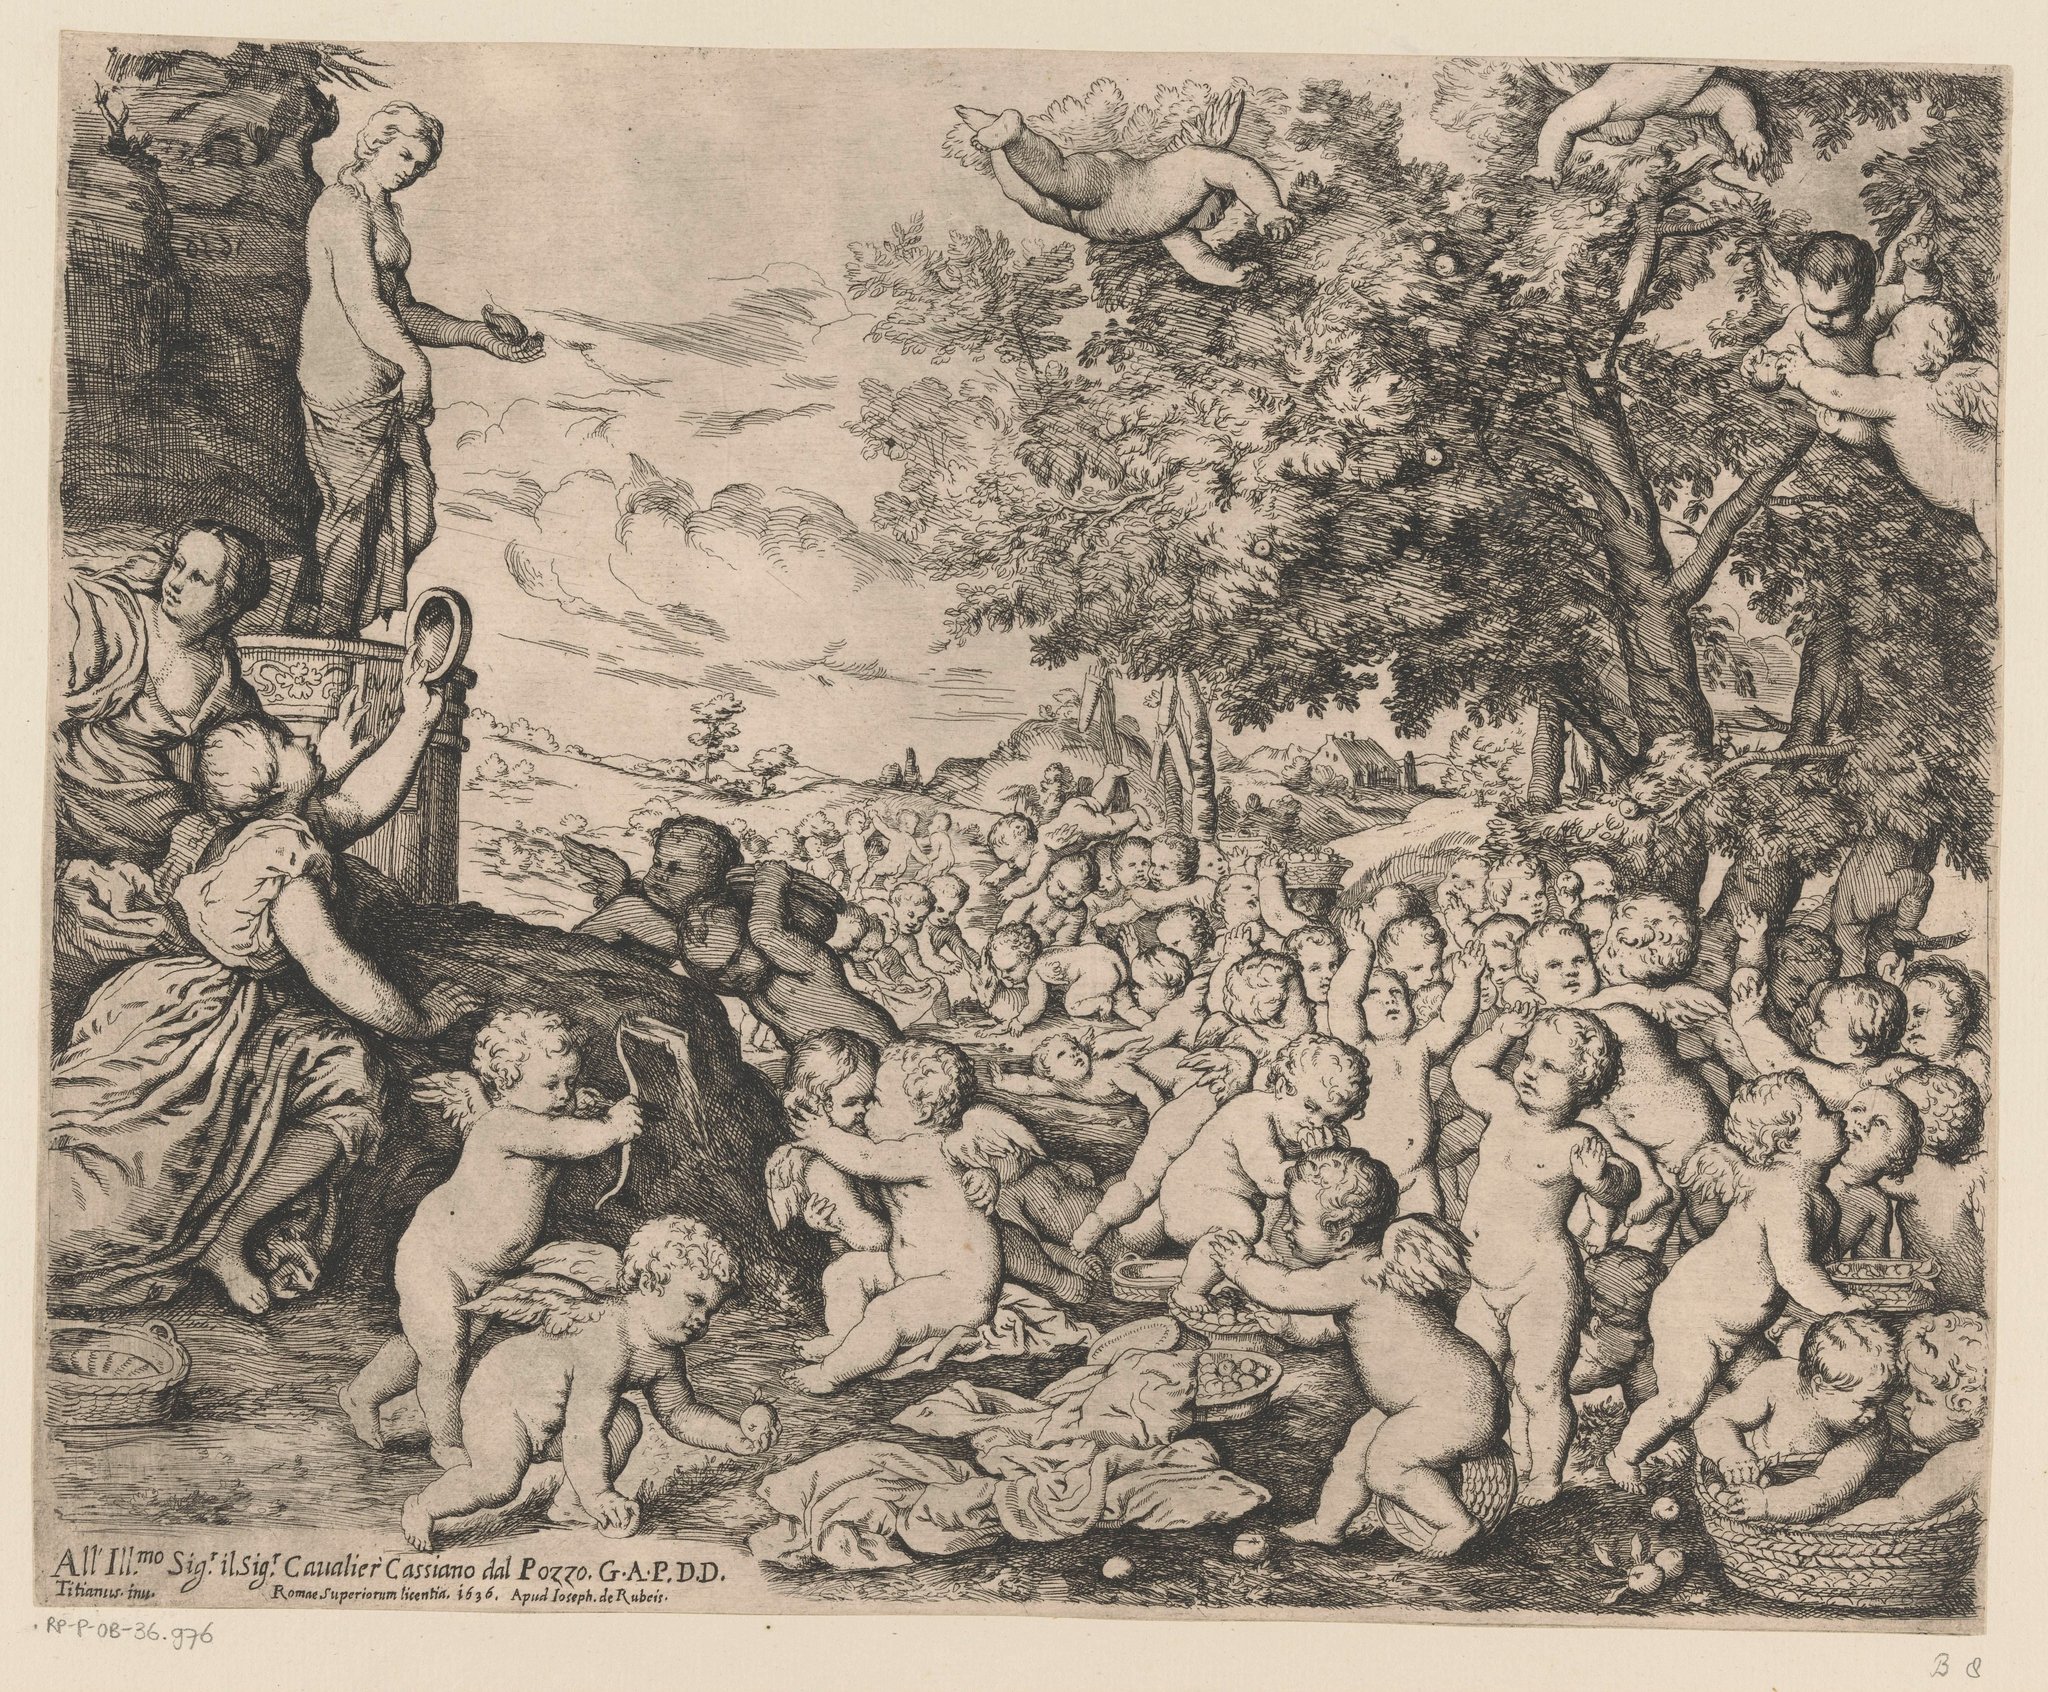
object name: print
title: Verering van Venus door putti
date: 1636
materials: paper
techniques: etching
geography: genoa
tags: worship of venus (philostratus, imagines ii 1), piece of sculpture, reproduction of a piece of sculpture, cupids: 'amores', 'amoretti', 'putti'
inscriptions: collector's mark: Lugt 240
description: Landschap met een grote groep putti die een beeld van de godin Venus vereert. Opdracht in het Italiaans linksonder.